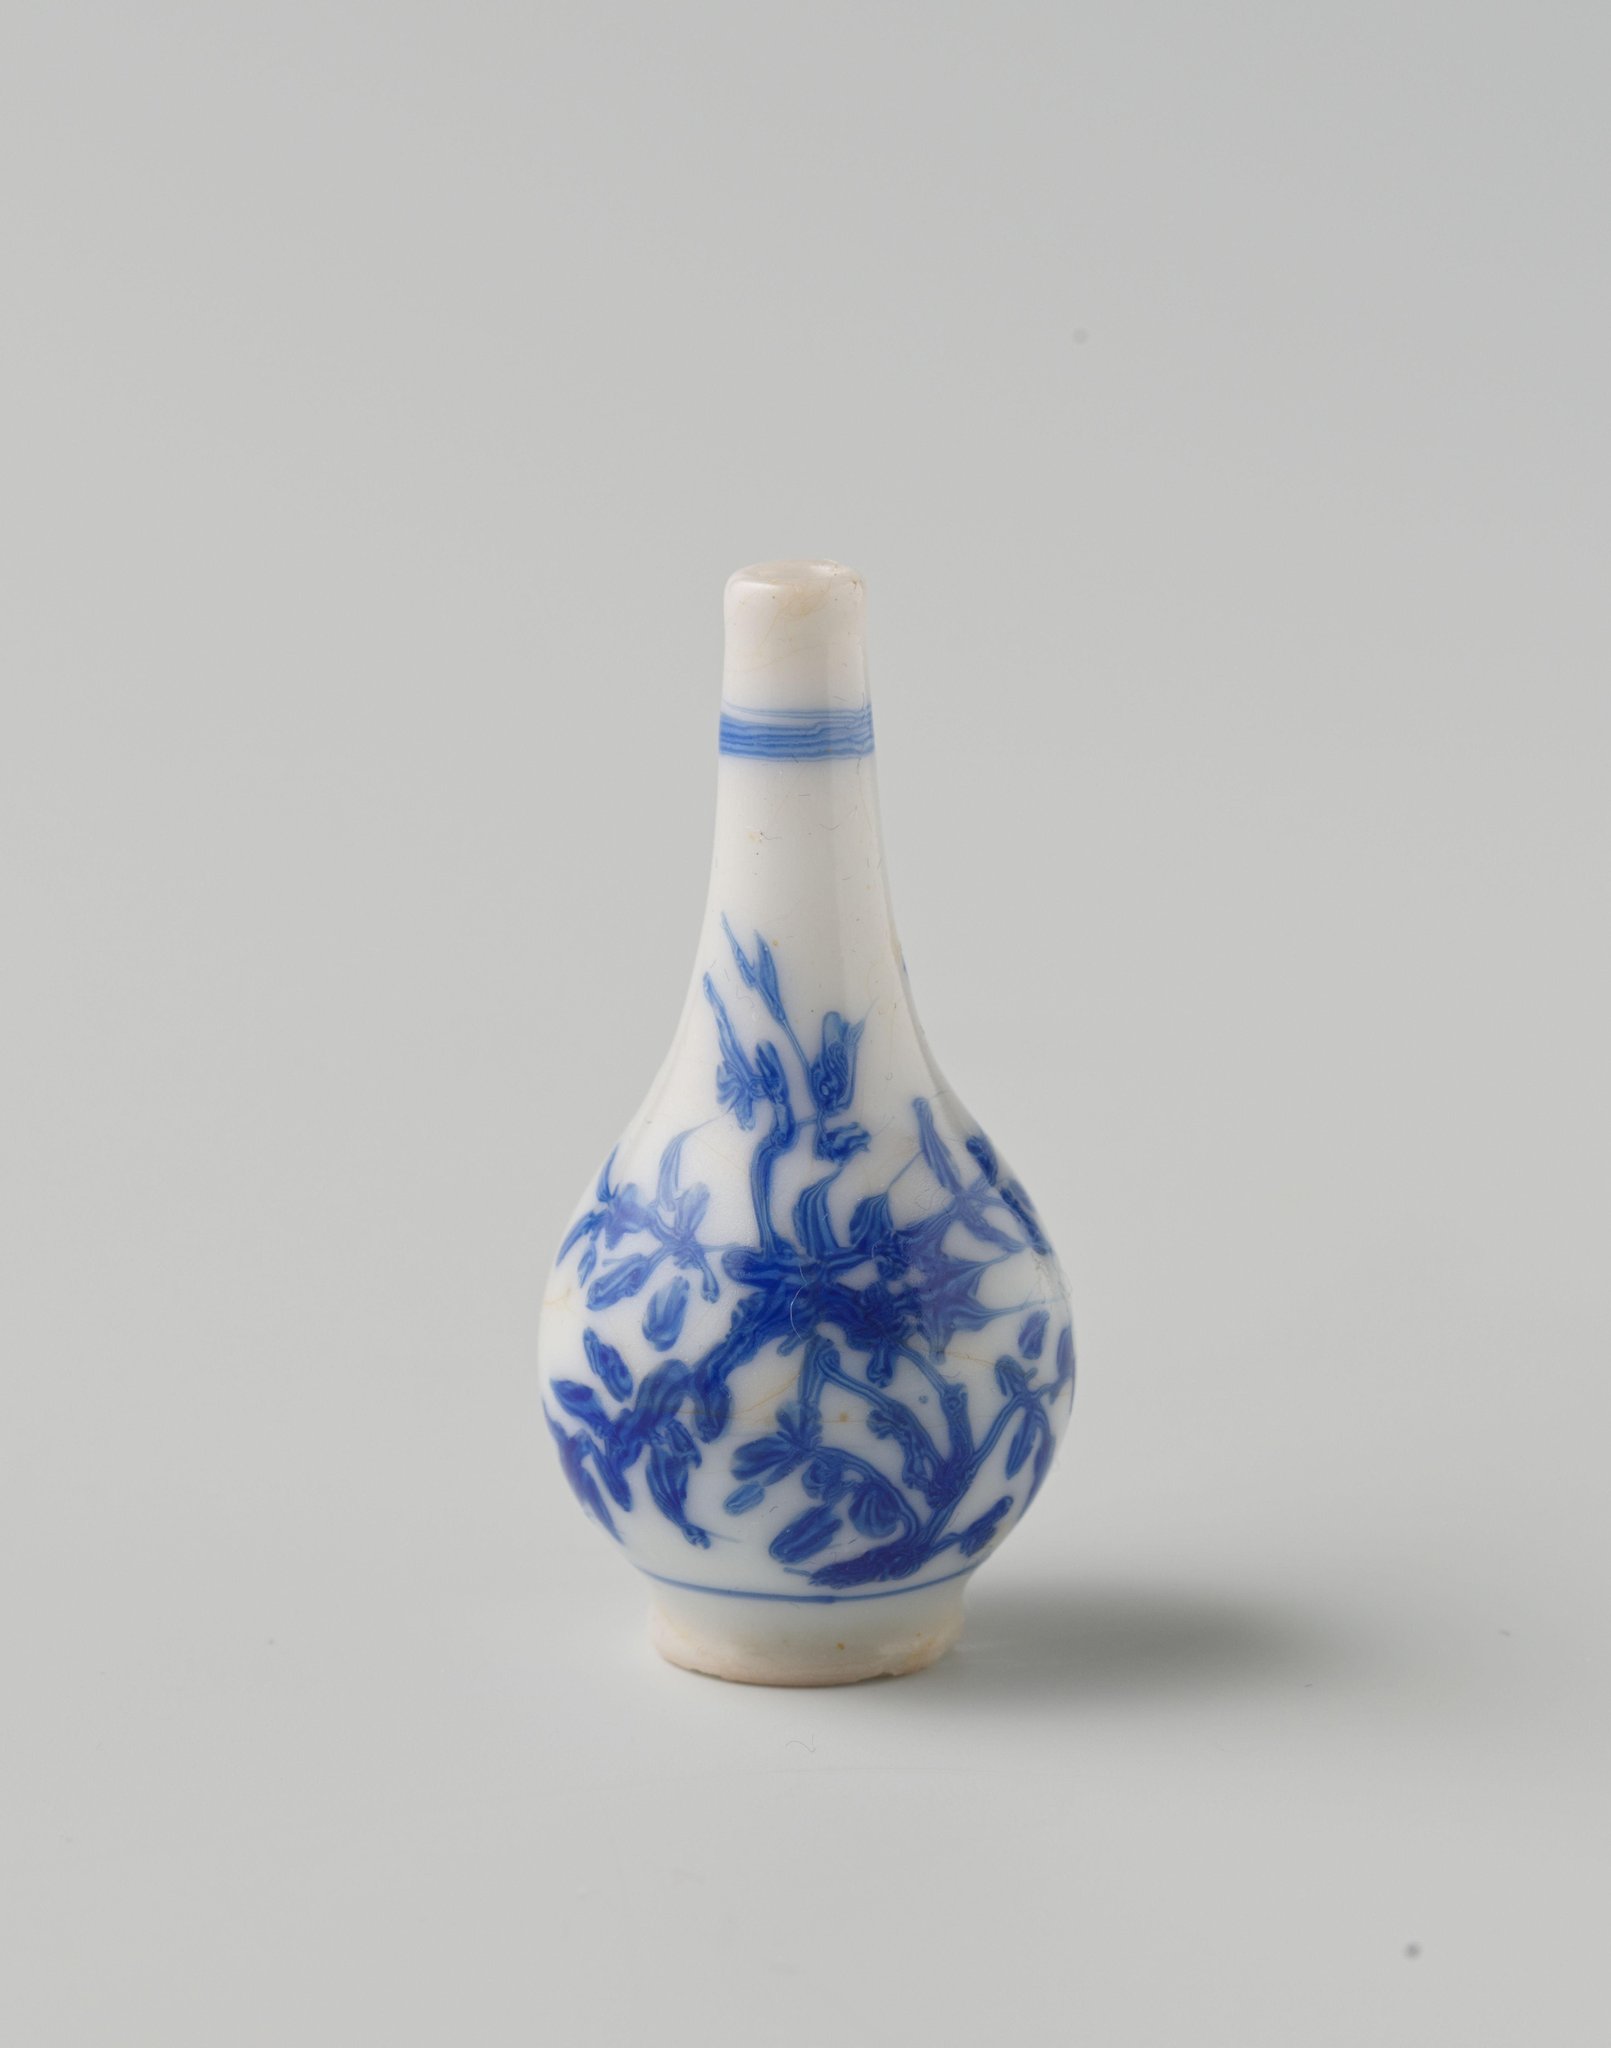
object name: bottle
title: Fles of vaas van melkglas met blauwe emailverf beschildering, imitatie Chinees porselein; peervormig op standring met decoratie van twee grote bloesemtakken.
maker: Anonymous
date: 1675-1710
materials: glass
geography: amsterdam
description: Fles of vaas van melkglas met blauwe emailverf beschildering, imitatie Chinees porselein; model peervormig op standring met decoratie van twee grote bloesemtakken.